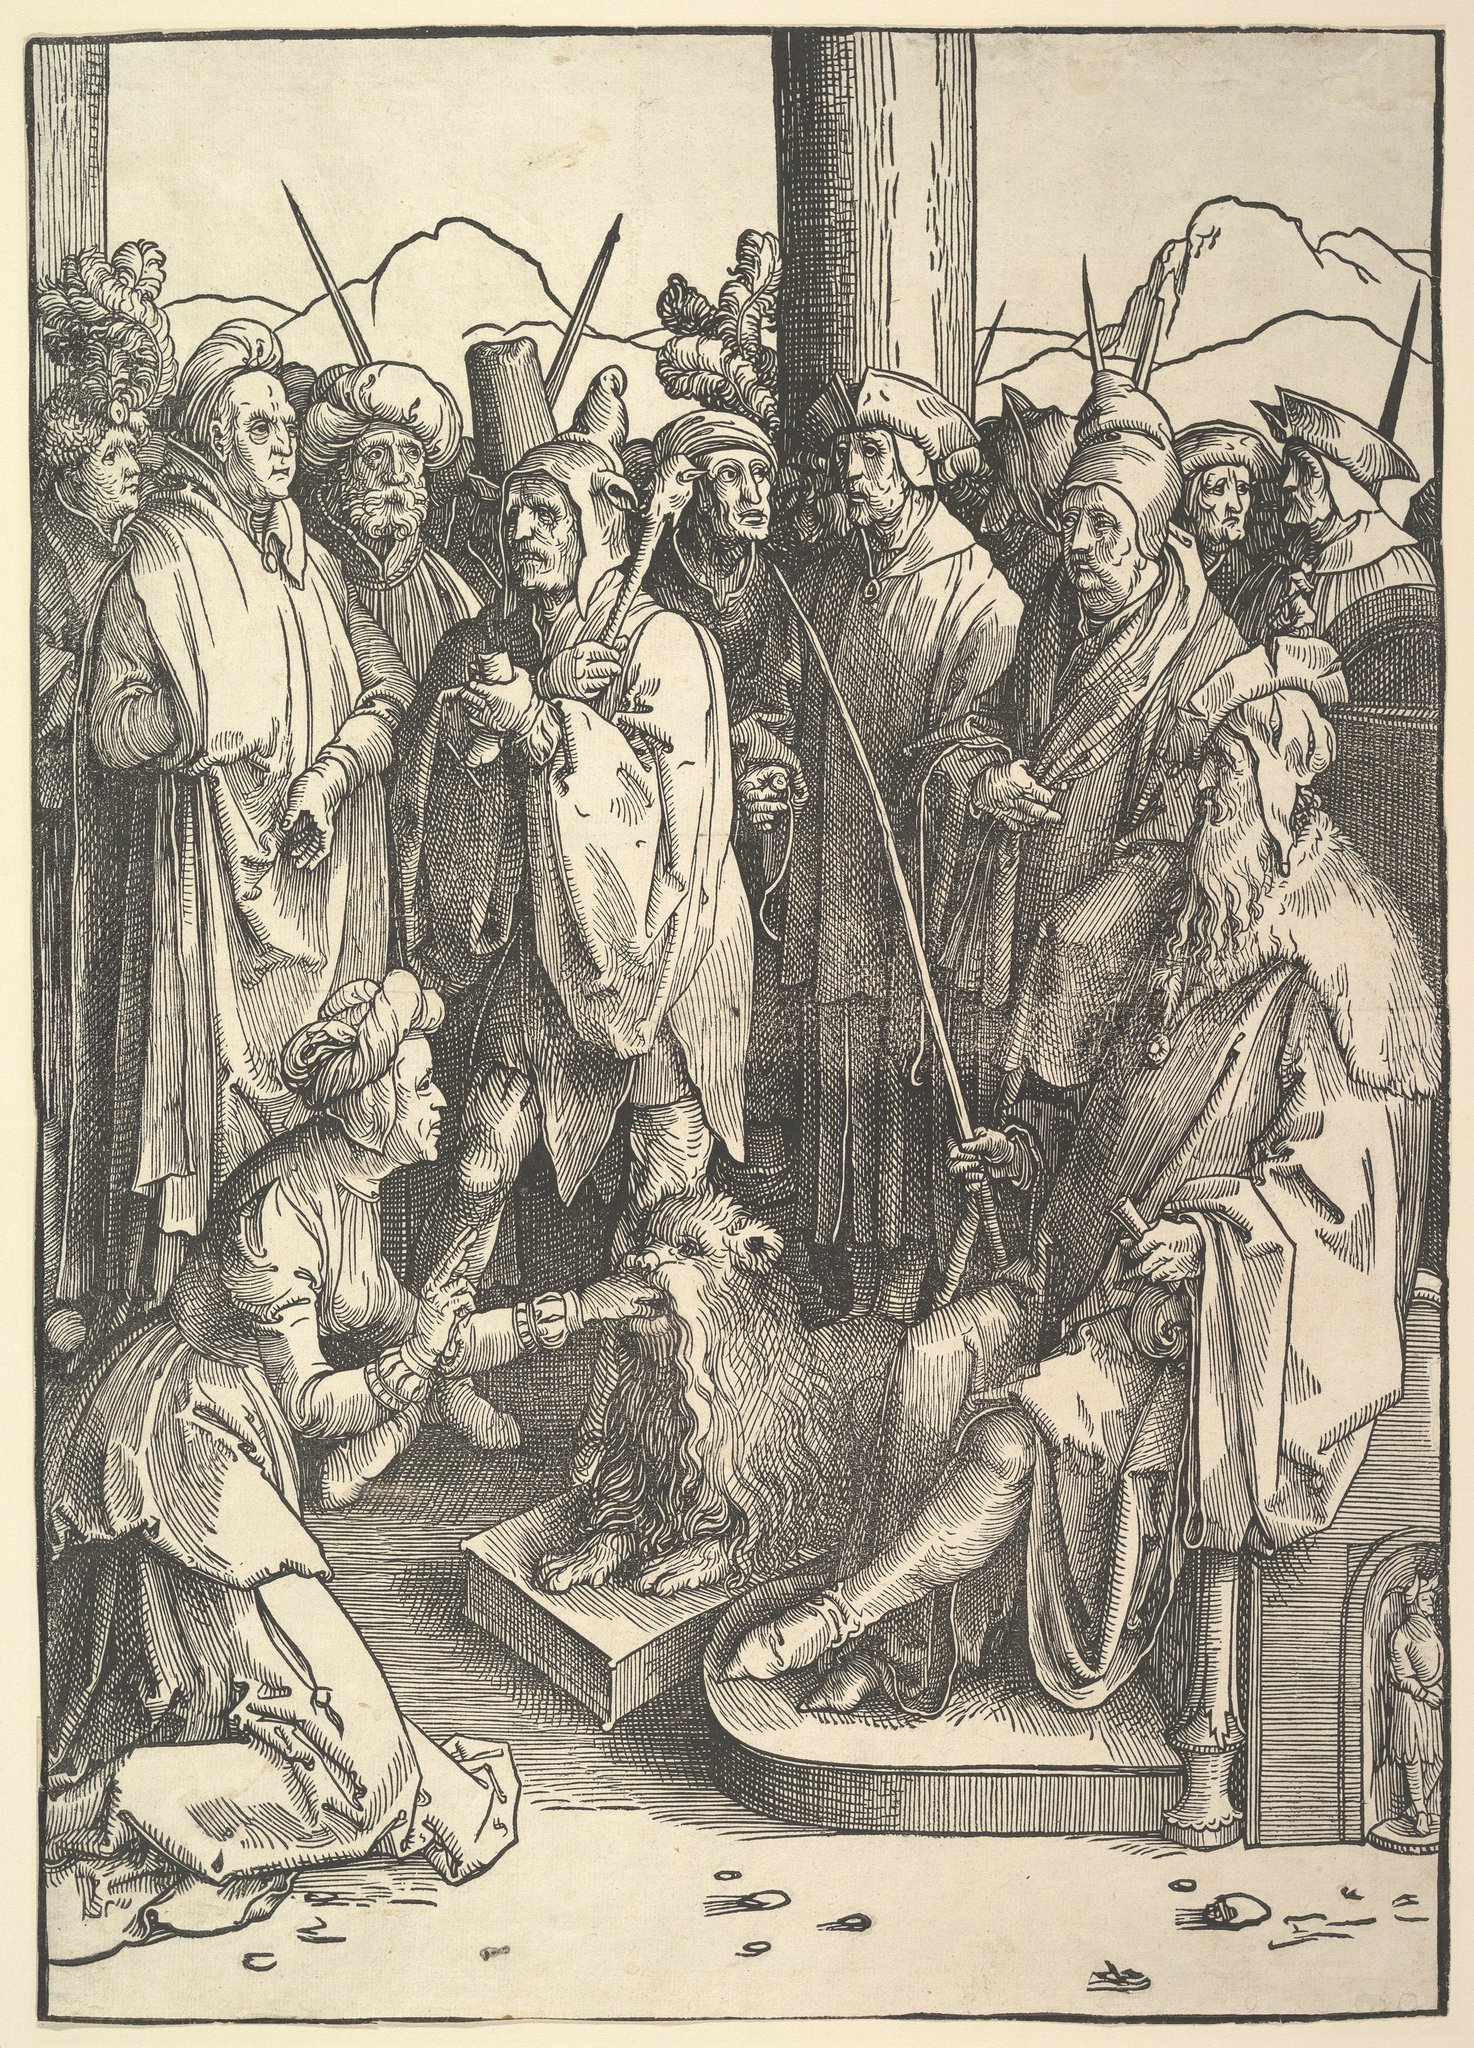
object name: print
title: The Mouth of Truth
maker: lucas van leyden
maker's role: artist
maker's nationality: netherlandish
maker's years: 1494-1533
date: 1514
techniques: woodcut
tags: lions,crowd